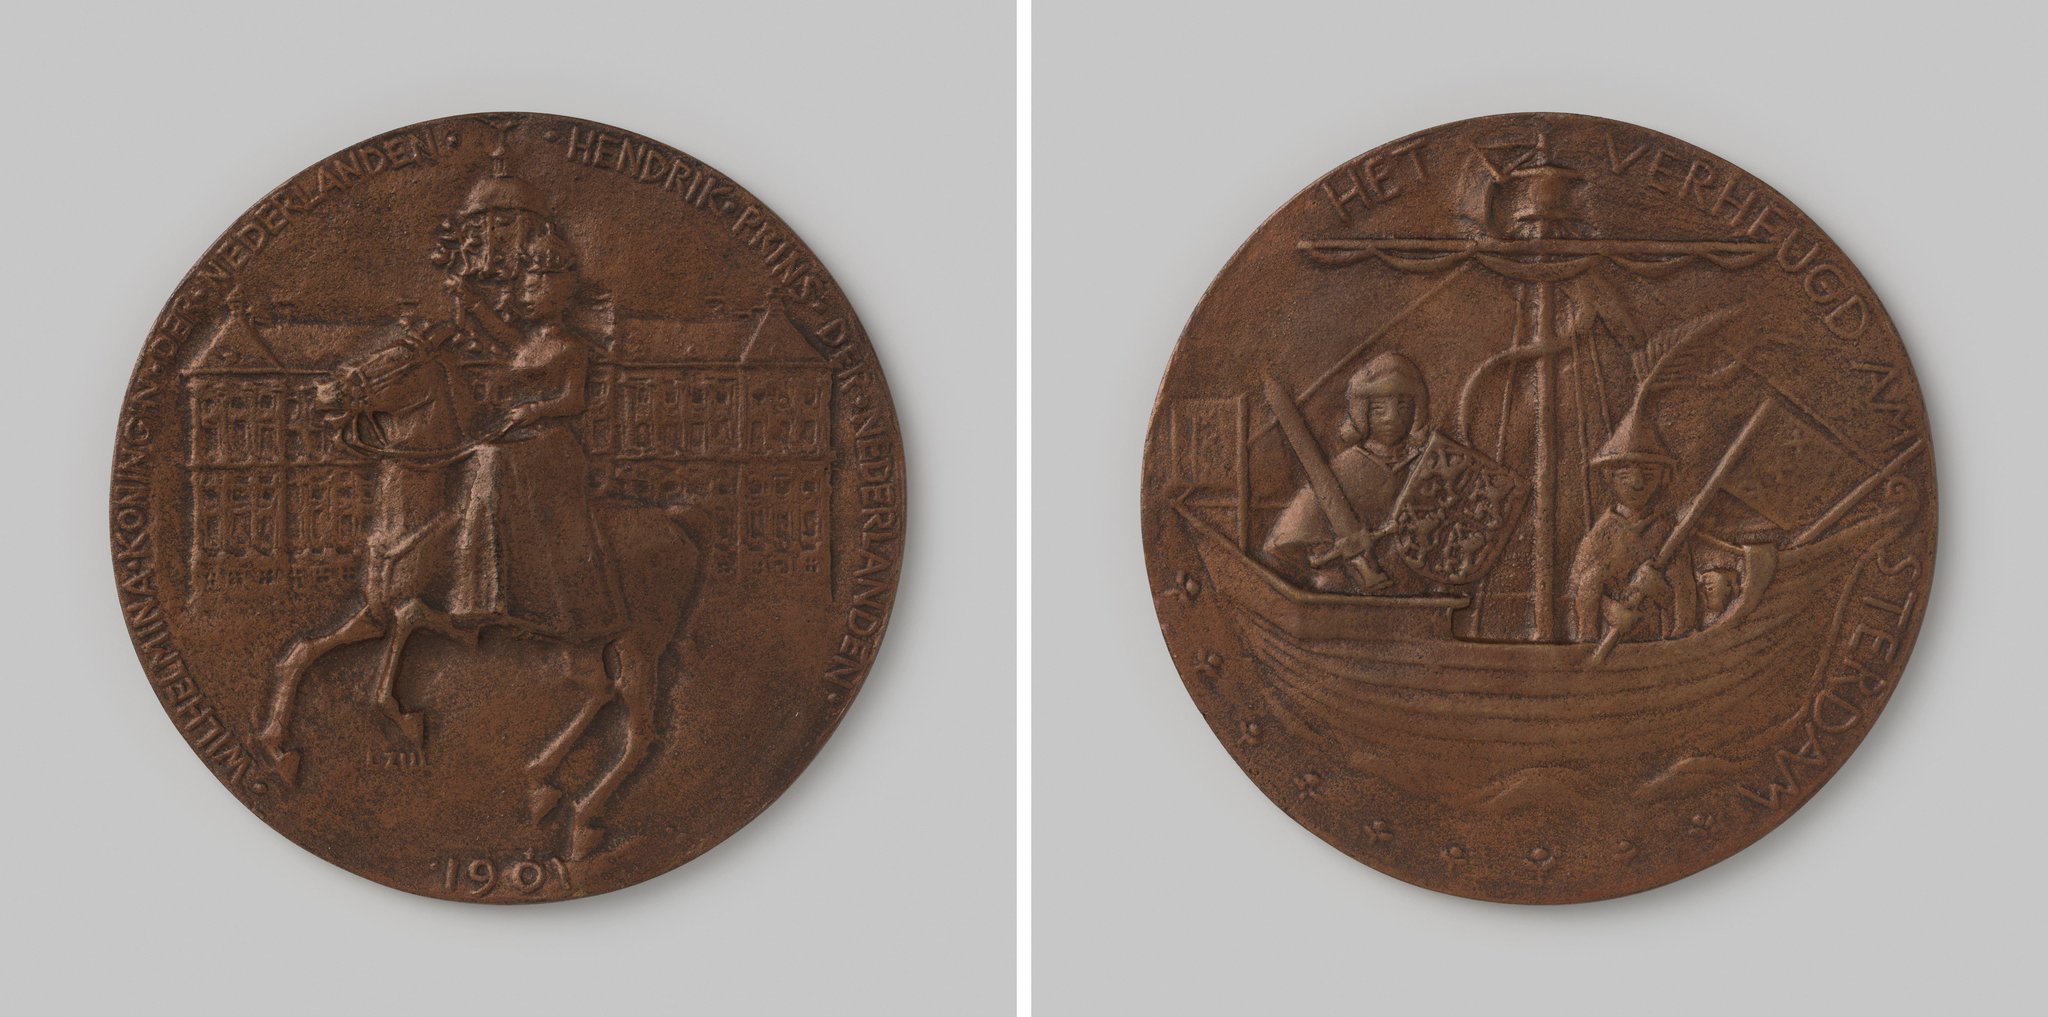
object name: history medal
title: Huwelijk van Koningin Wilhelmina met Hendrik van Mecklenburg-Schwerin te Amsterdam 1901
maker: lambertus zijl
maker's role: designer, draughtsman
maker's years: 1866-1947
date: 1901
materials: bronze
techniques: casting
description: Grote gegoten bronzen penning, op de voorzijde Wilhelmina te paard naar links voor het Koninklijk Paleis te Amsterdam met omschrift, op de keerzijde het koggeschip uit het zegel van de stad Amsterdam met omschrift.